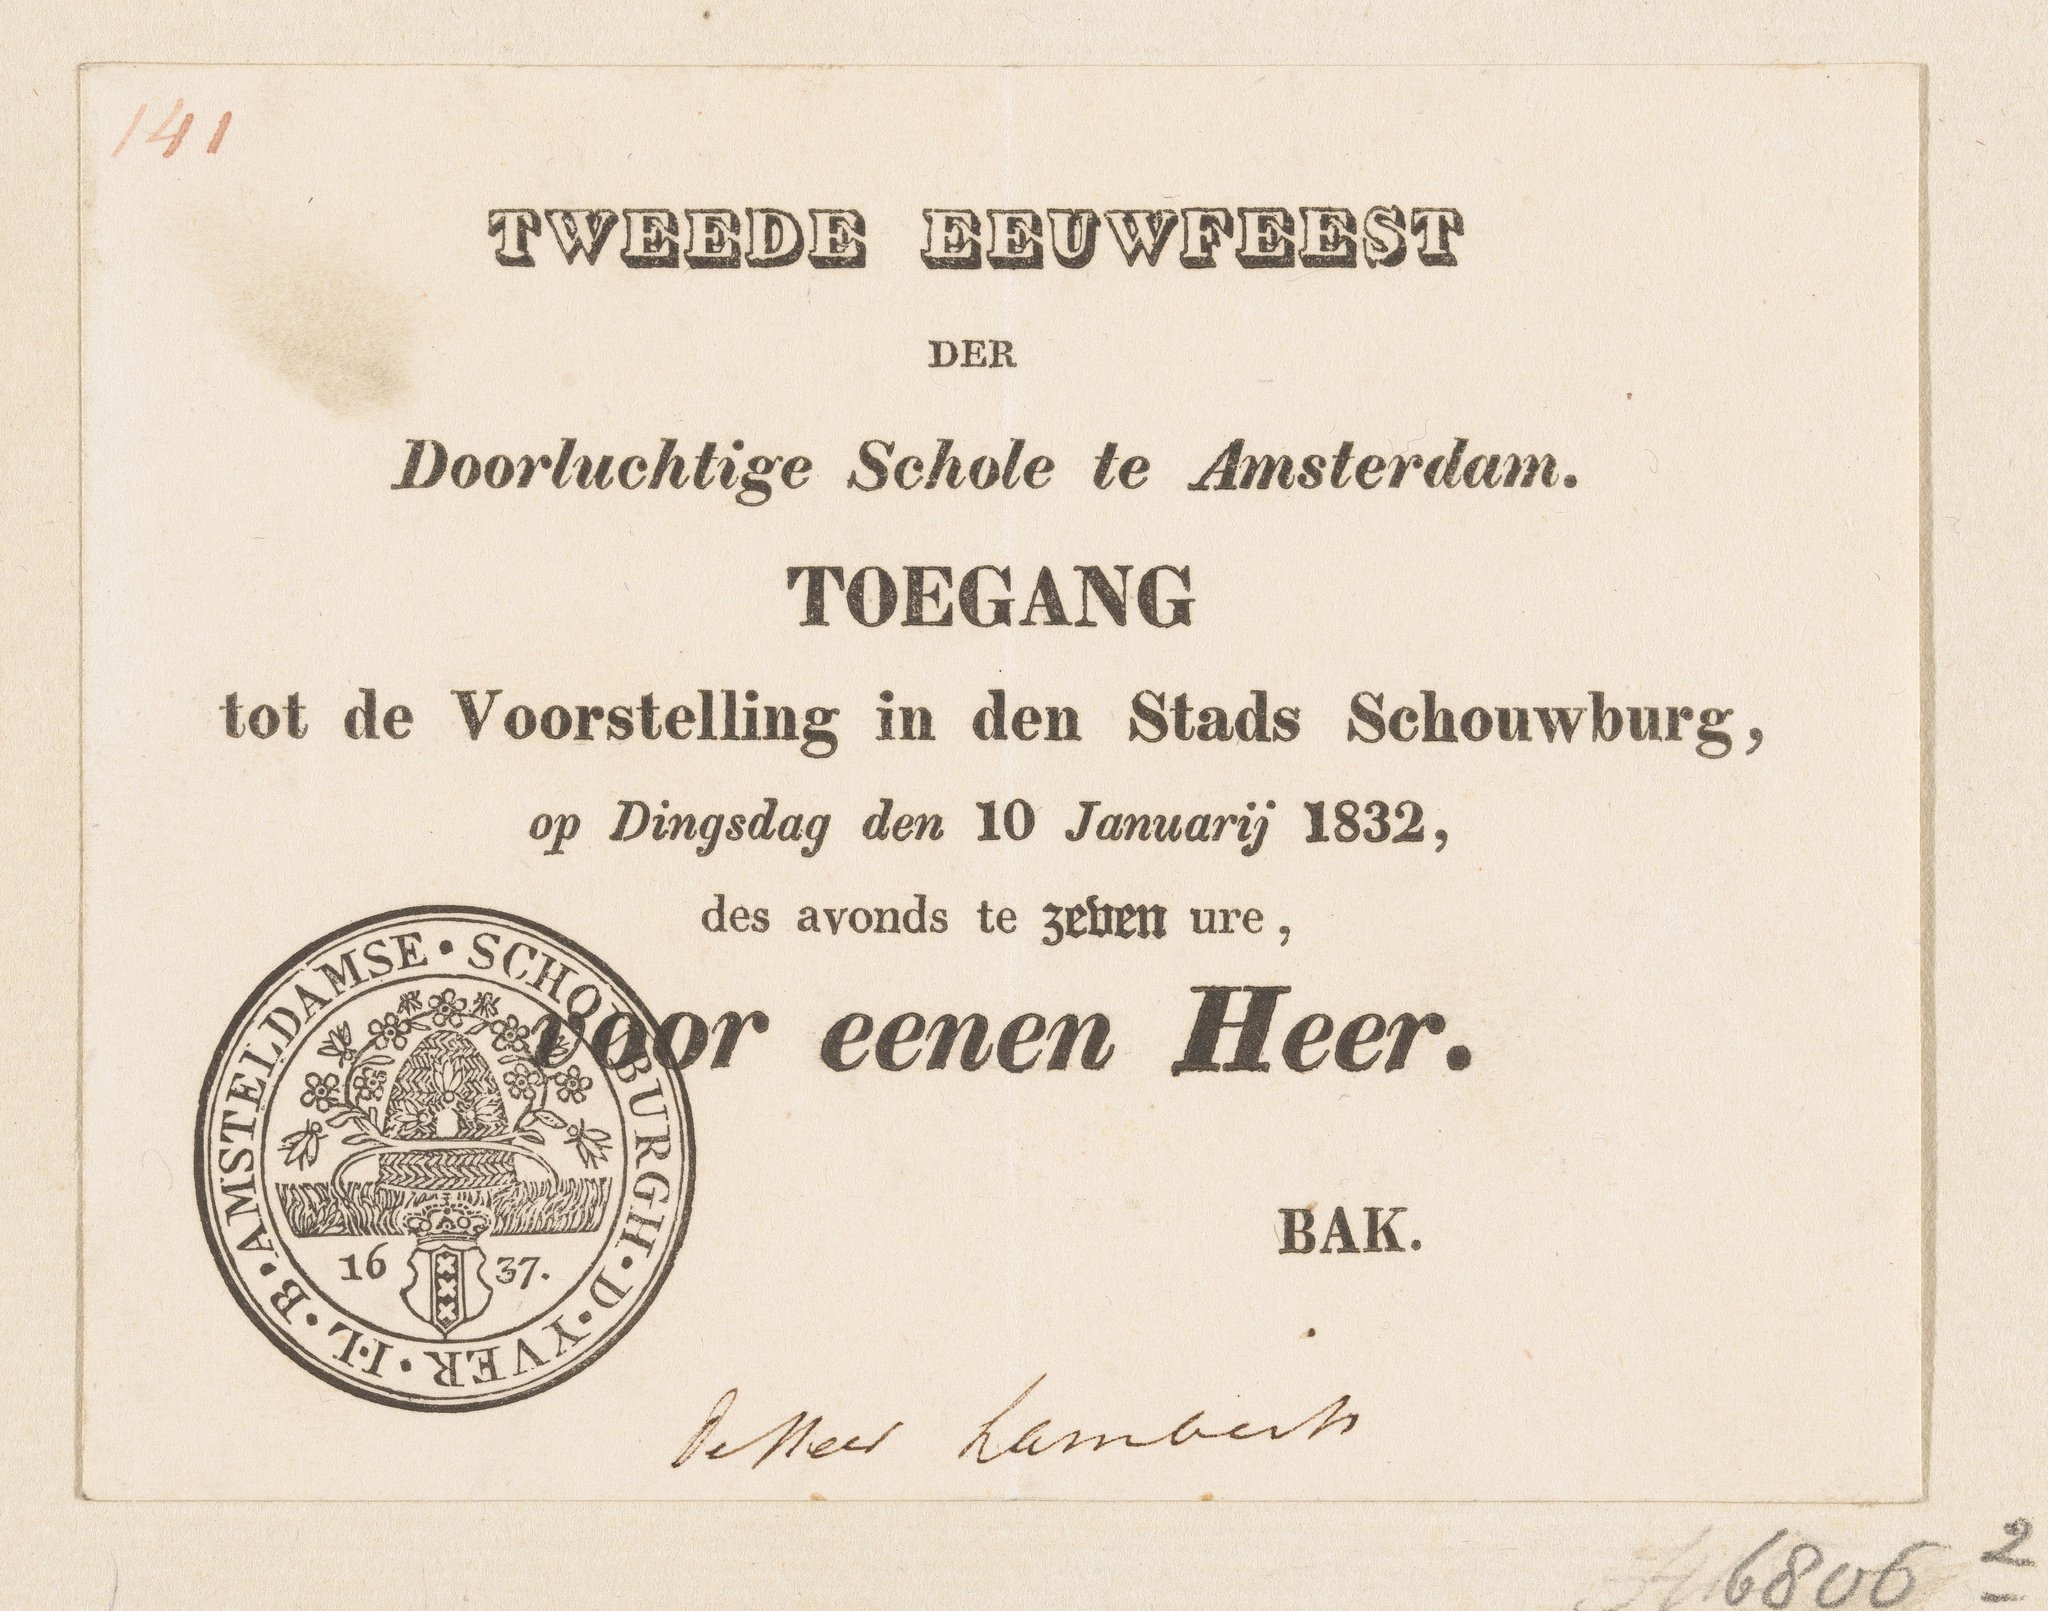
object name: admission ticket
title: Kaartje voor de toneelvoorstelling op het tweede eeuwfeest van het Athenaeum Illustre te Amsterdam, 1832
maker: Anonymous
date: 1832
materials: paper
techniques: letterpress printing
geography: amsterdam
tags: athenaeum illustre, stadsschouwburg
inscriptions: collector's mark: Lugt 2228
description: Vrijkaartje 'voor eenen Heer', rang 'bak', voor de toneelavond ter gelegenheid van het tweede eeuwfeest (1632-1832) van het Athenaeum Illustre te Amsterdam, in de Stadsschouwburg te Amsterdam, 10 januari 1832. Linksonder het vignet van de Stadsschouwburg.